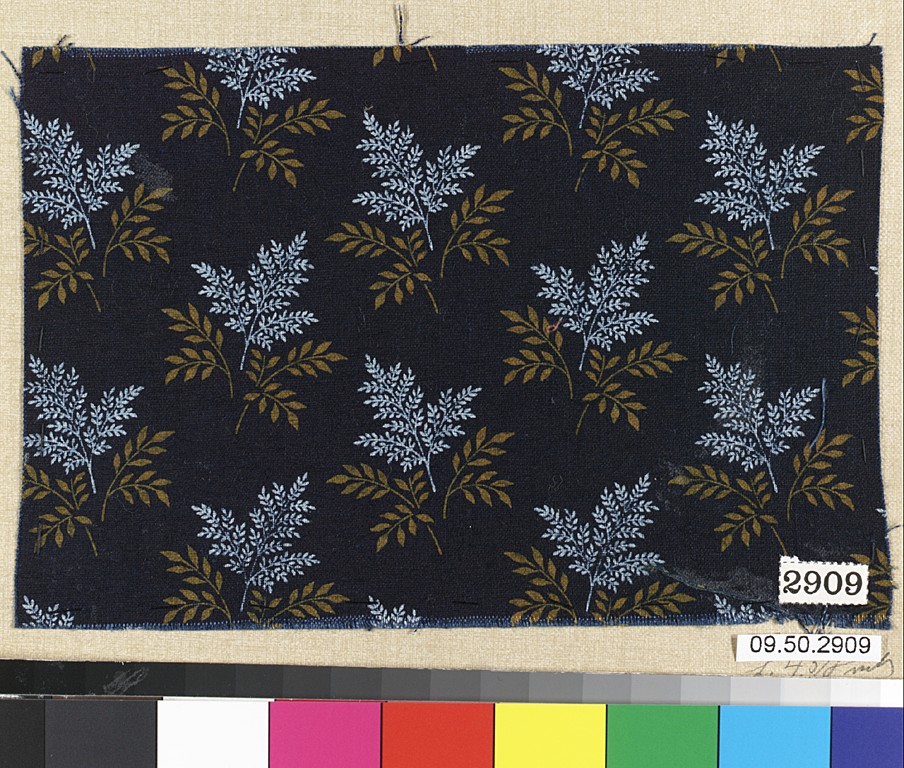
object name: piece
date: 1801-1900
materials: cotton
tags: leaves